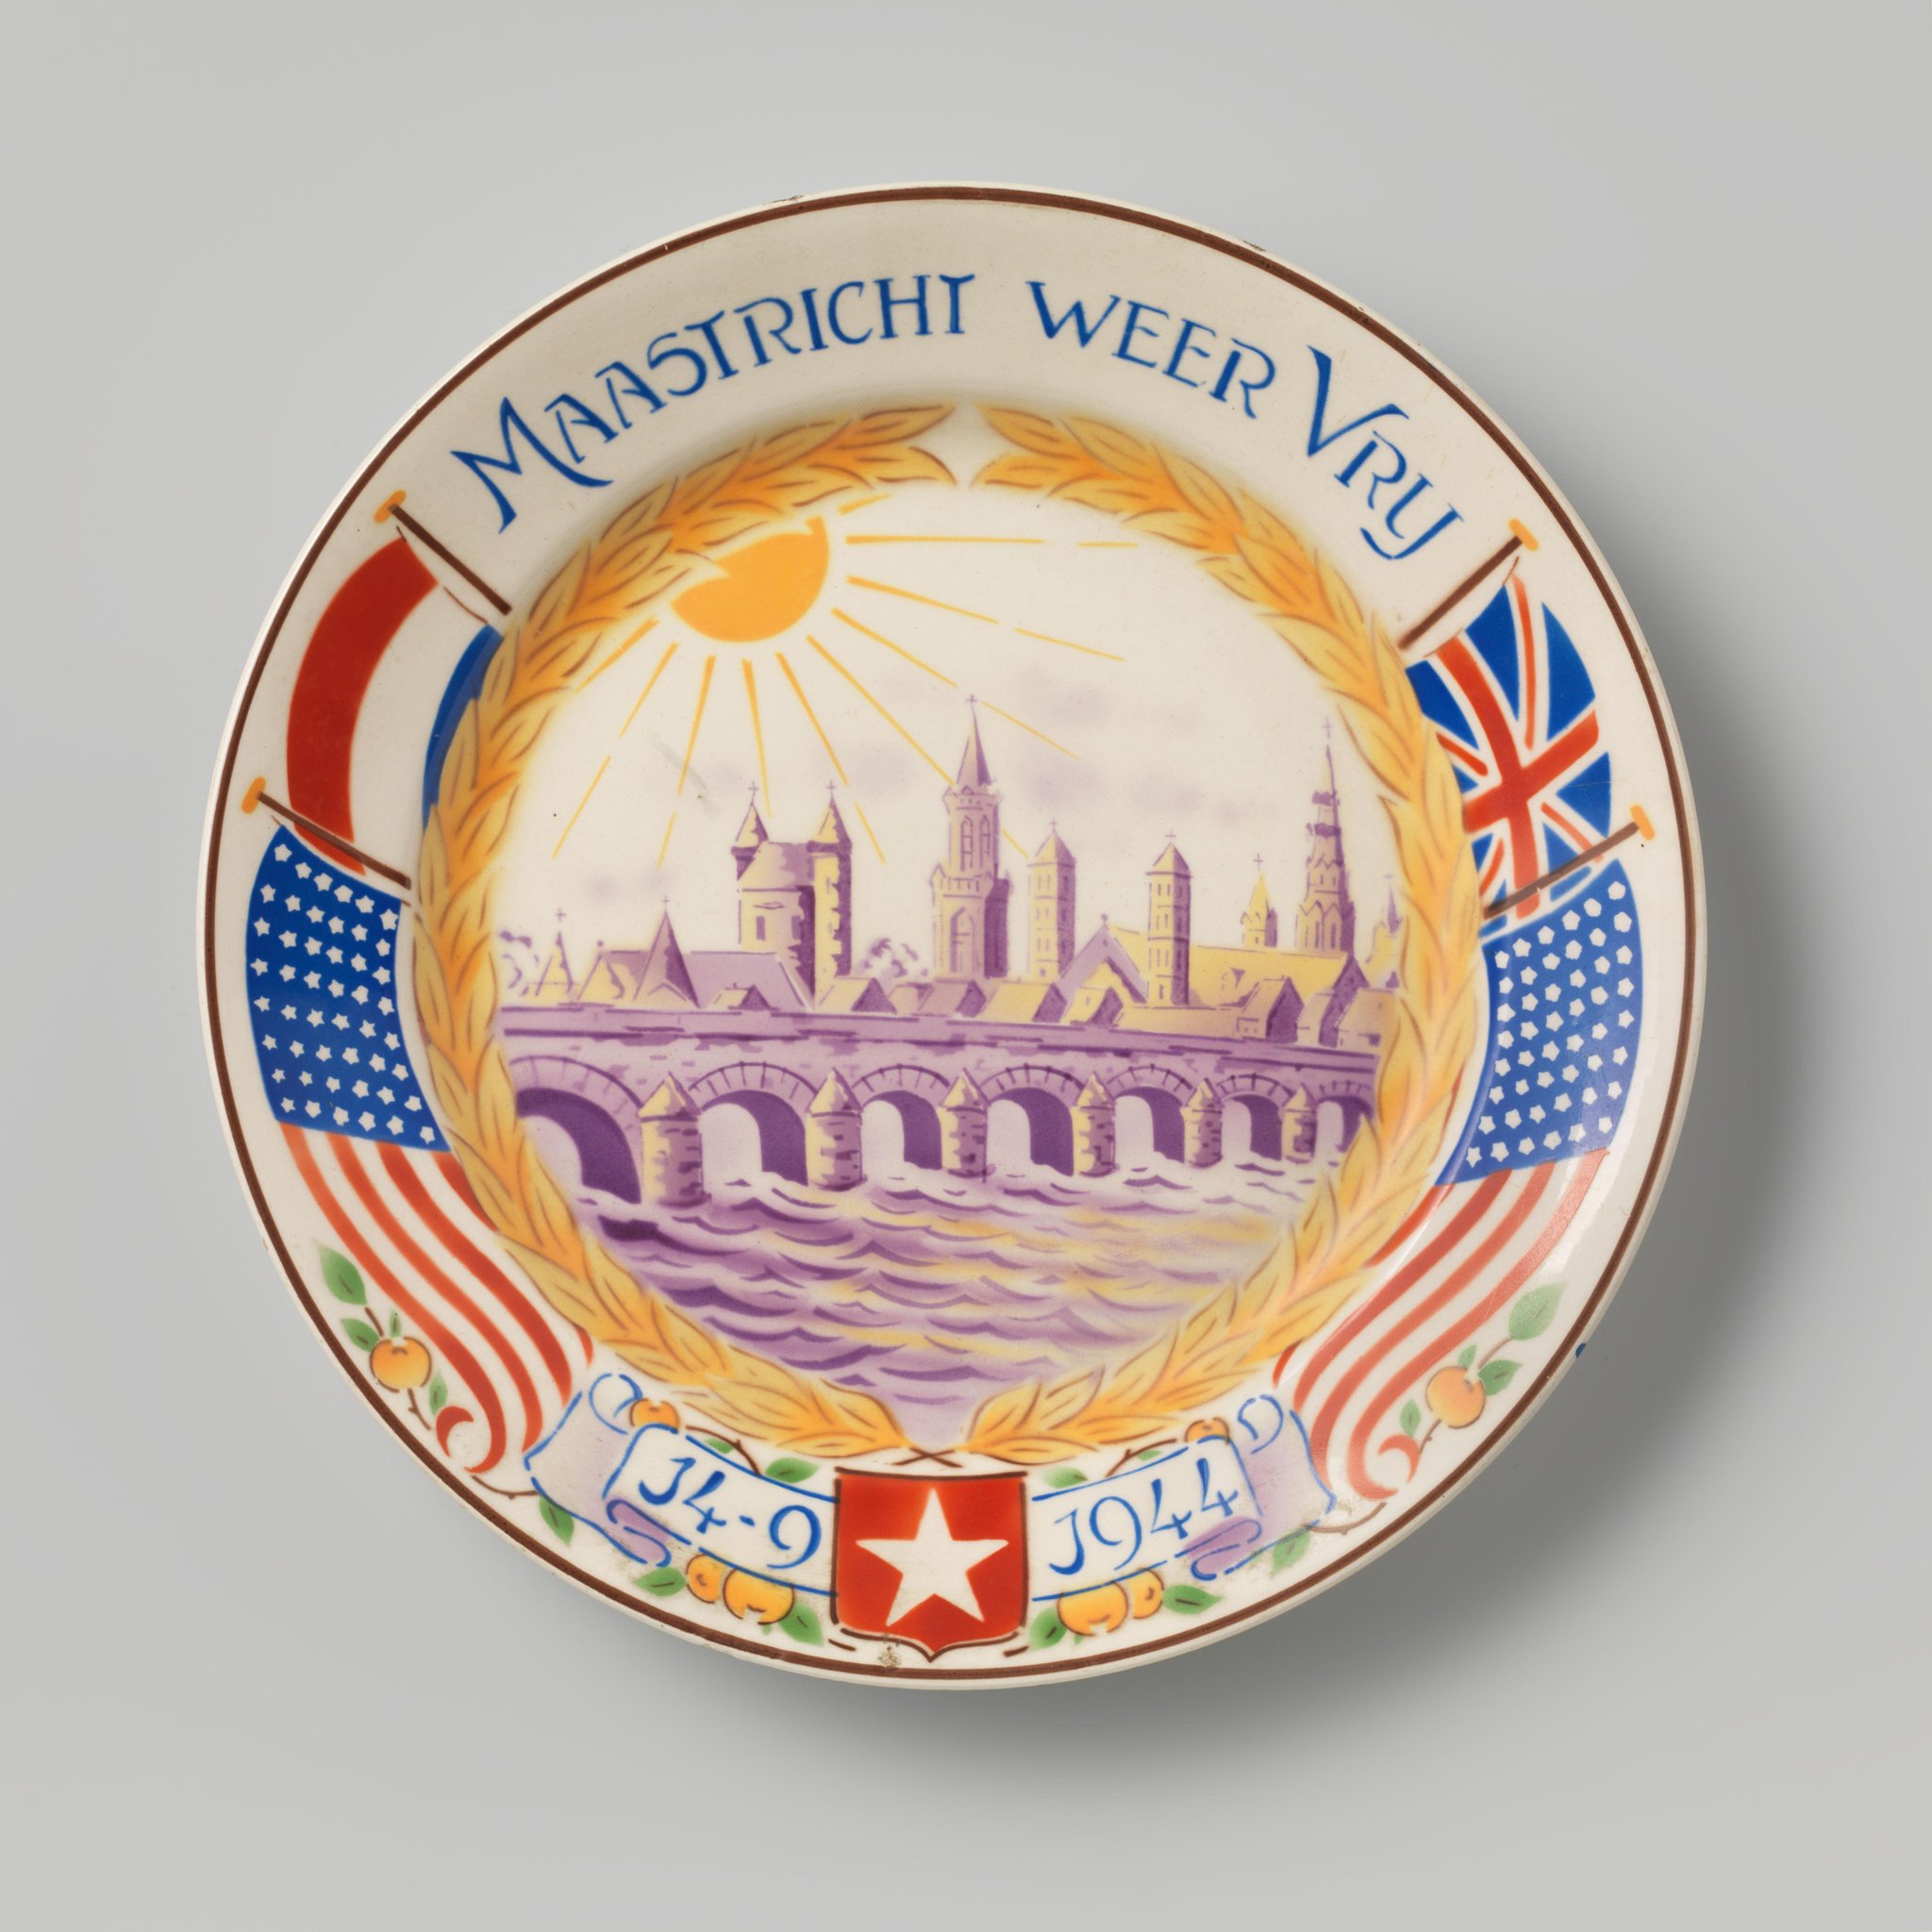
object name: commemorative plate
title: Maastricht weer vrij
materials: earthenware, glaze, paint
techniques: firing, painted, vitrification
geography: maastricht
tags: maastricht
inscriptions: mark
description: Bord met stadsgezicht van Maastricht met zon. Buitenrand aan linkerzijde: vlag van Nederland en Verenigde Staten; rechts: vlag van Groot-Britanië en Verenigde Staten. Keerzijde: gemerkt en twee gaatjes in buitenrand